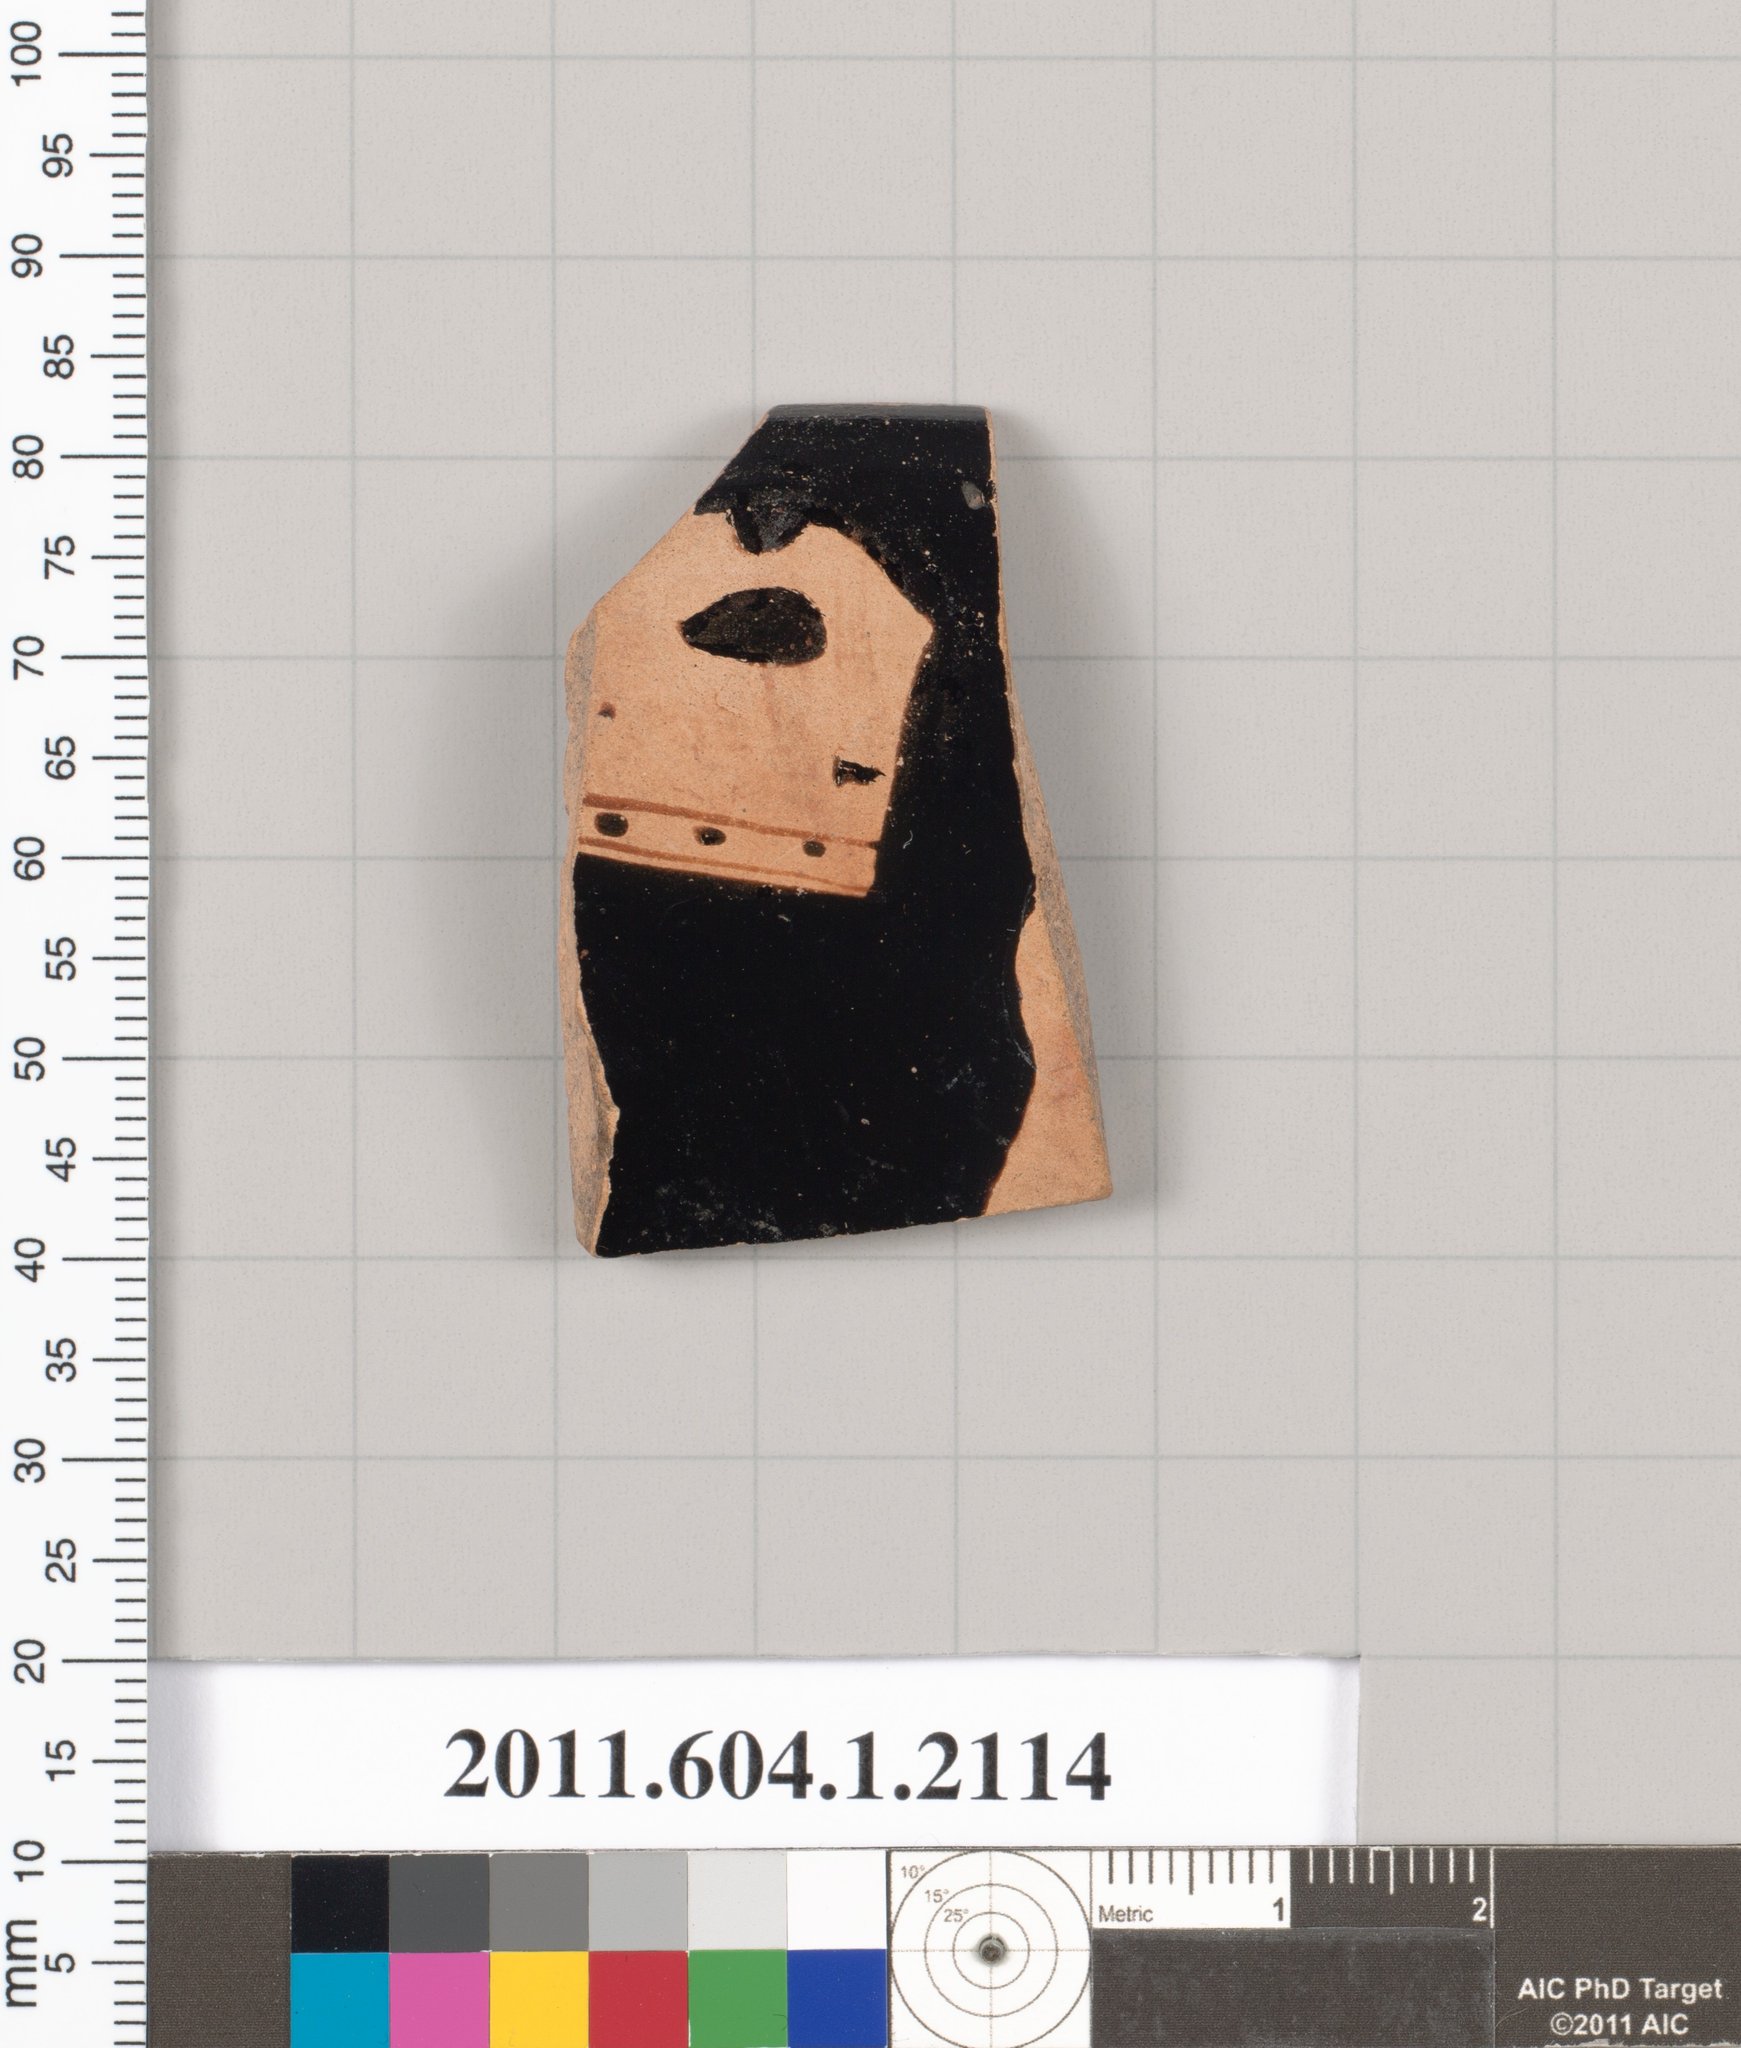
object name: kylix fragment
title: Terracotta rim fragment of a kylix (drinking cup)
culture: greek, attic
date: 467-435 BCE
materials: terracotta